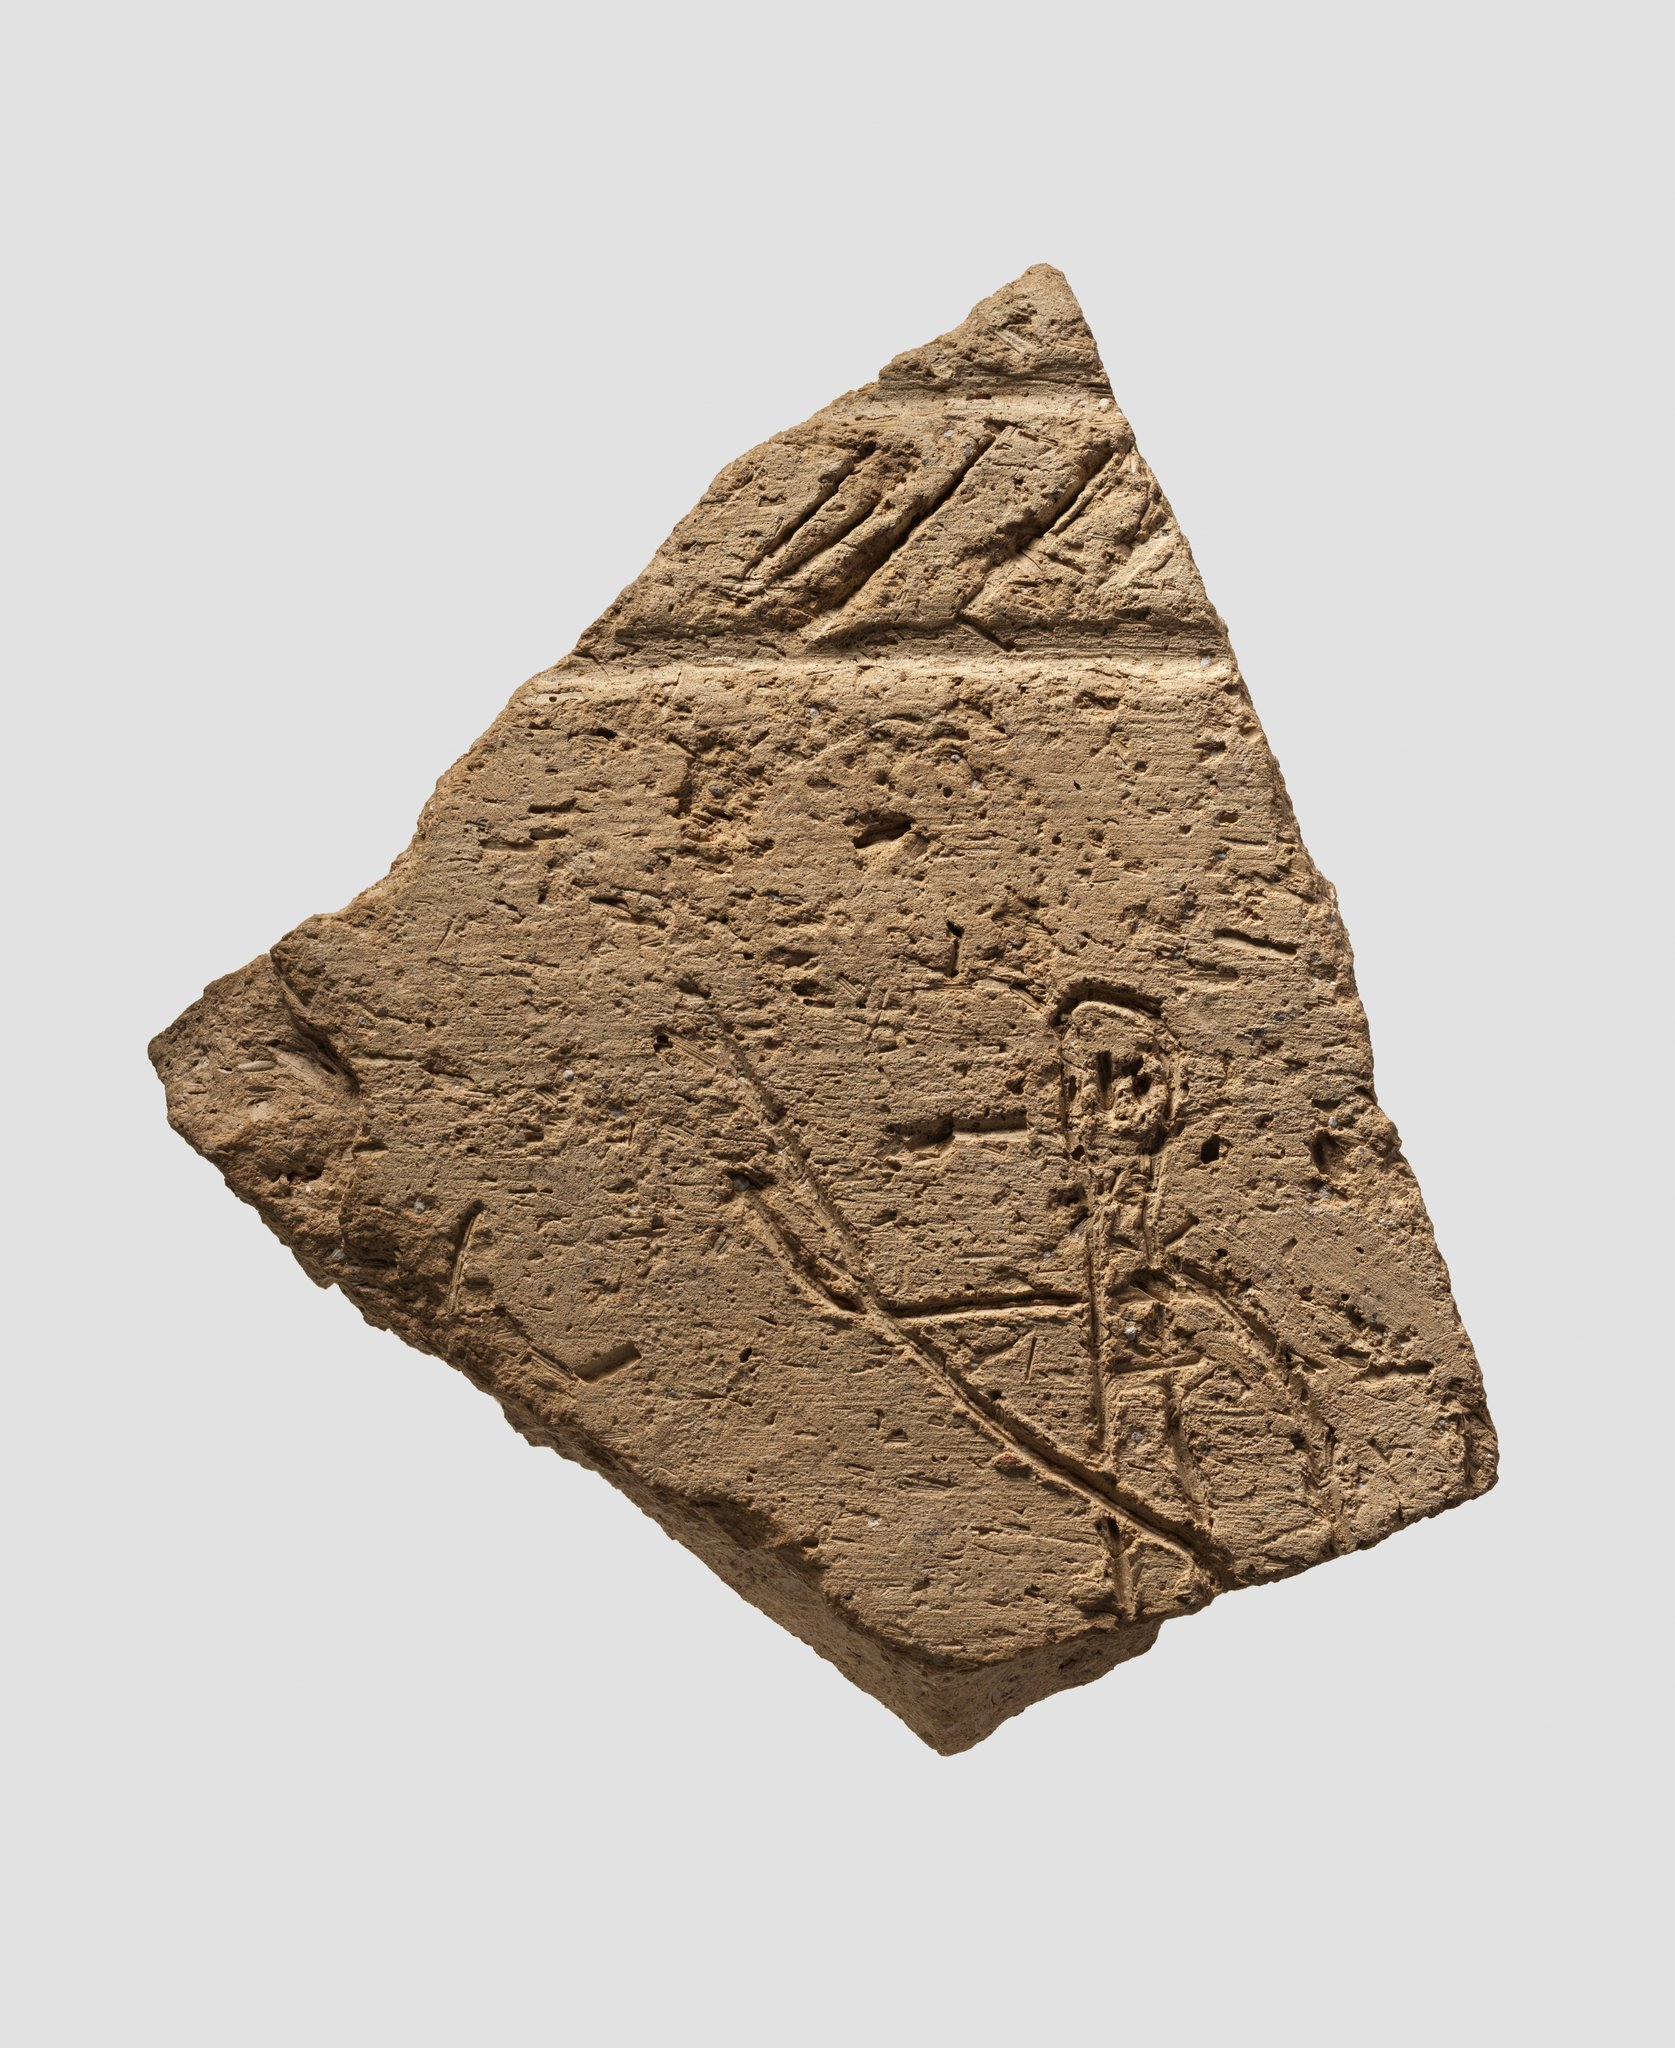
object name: jar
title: Jar sherd with incised decoration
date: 2333-2001 BCE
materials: ceramic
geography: mesopotamia